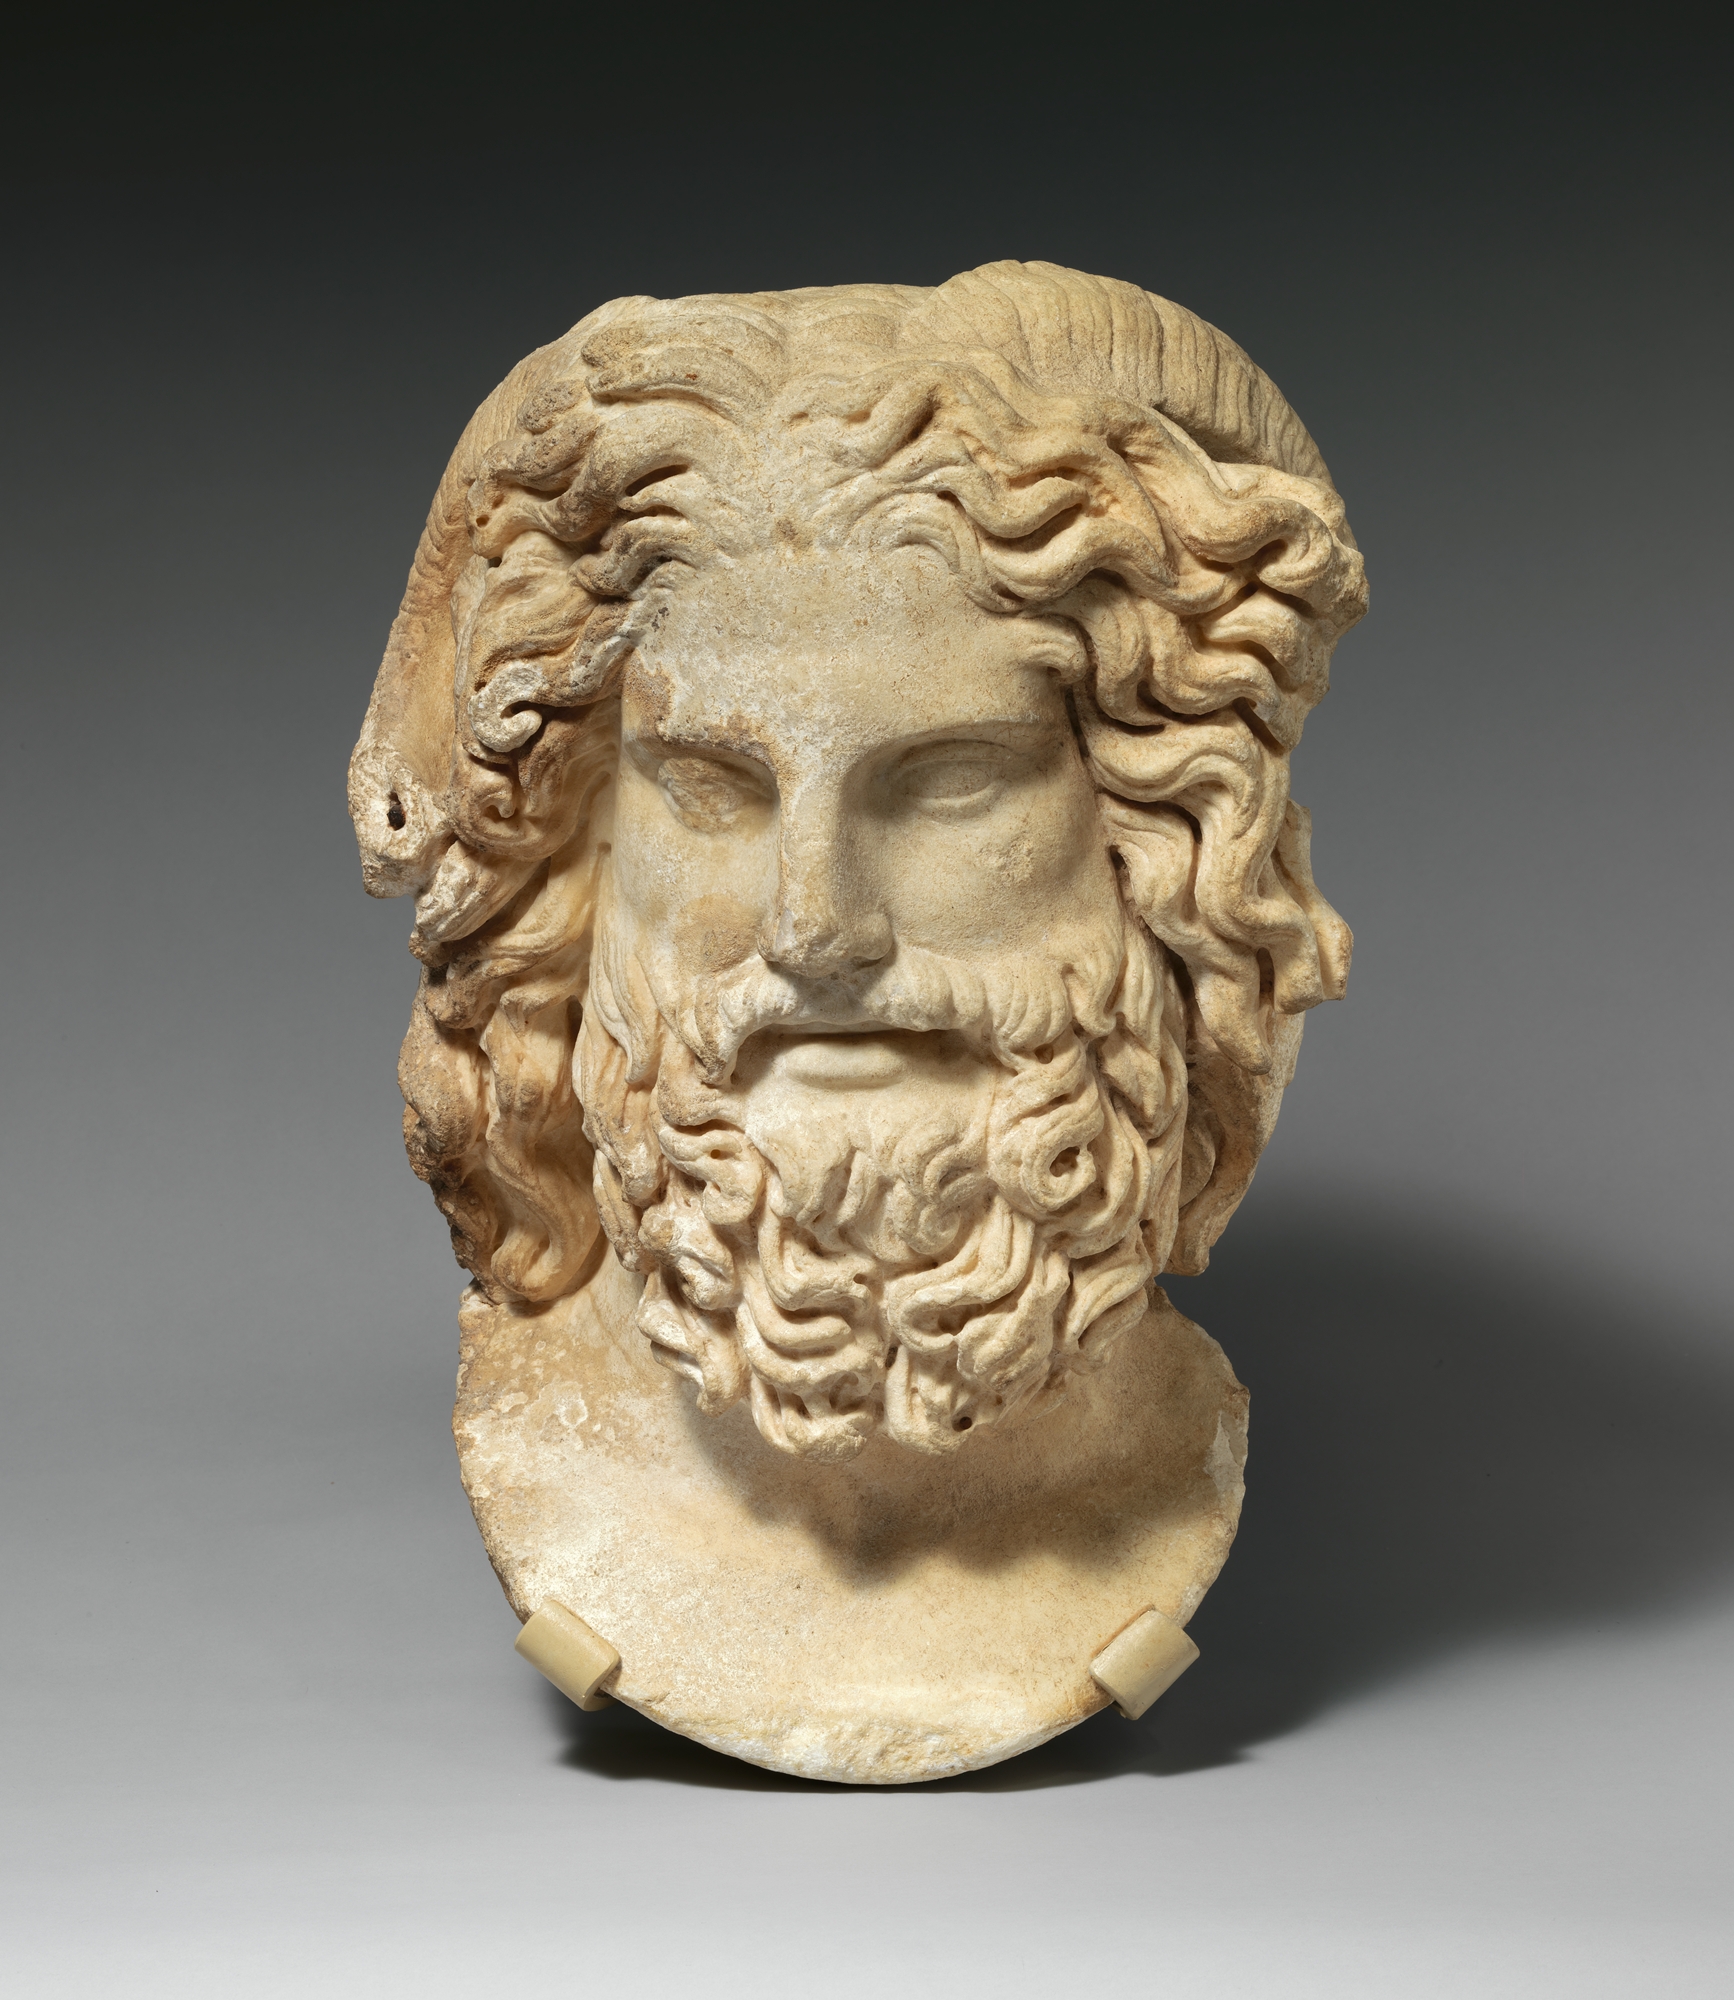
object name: head of zeus ammon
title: Marble head of Zeus Ammon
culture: roman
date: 120-160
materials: marble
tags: heads,men